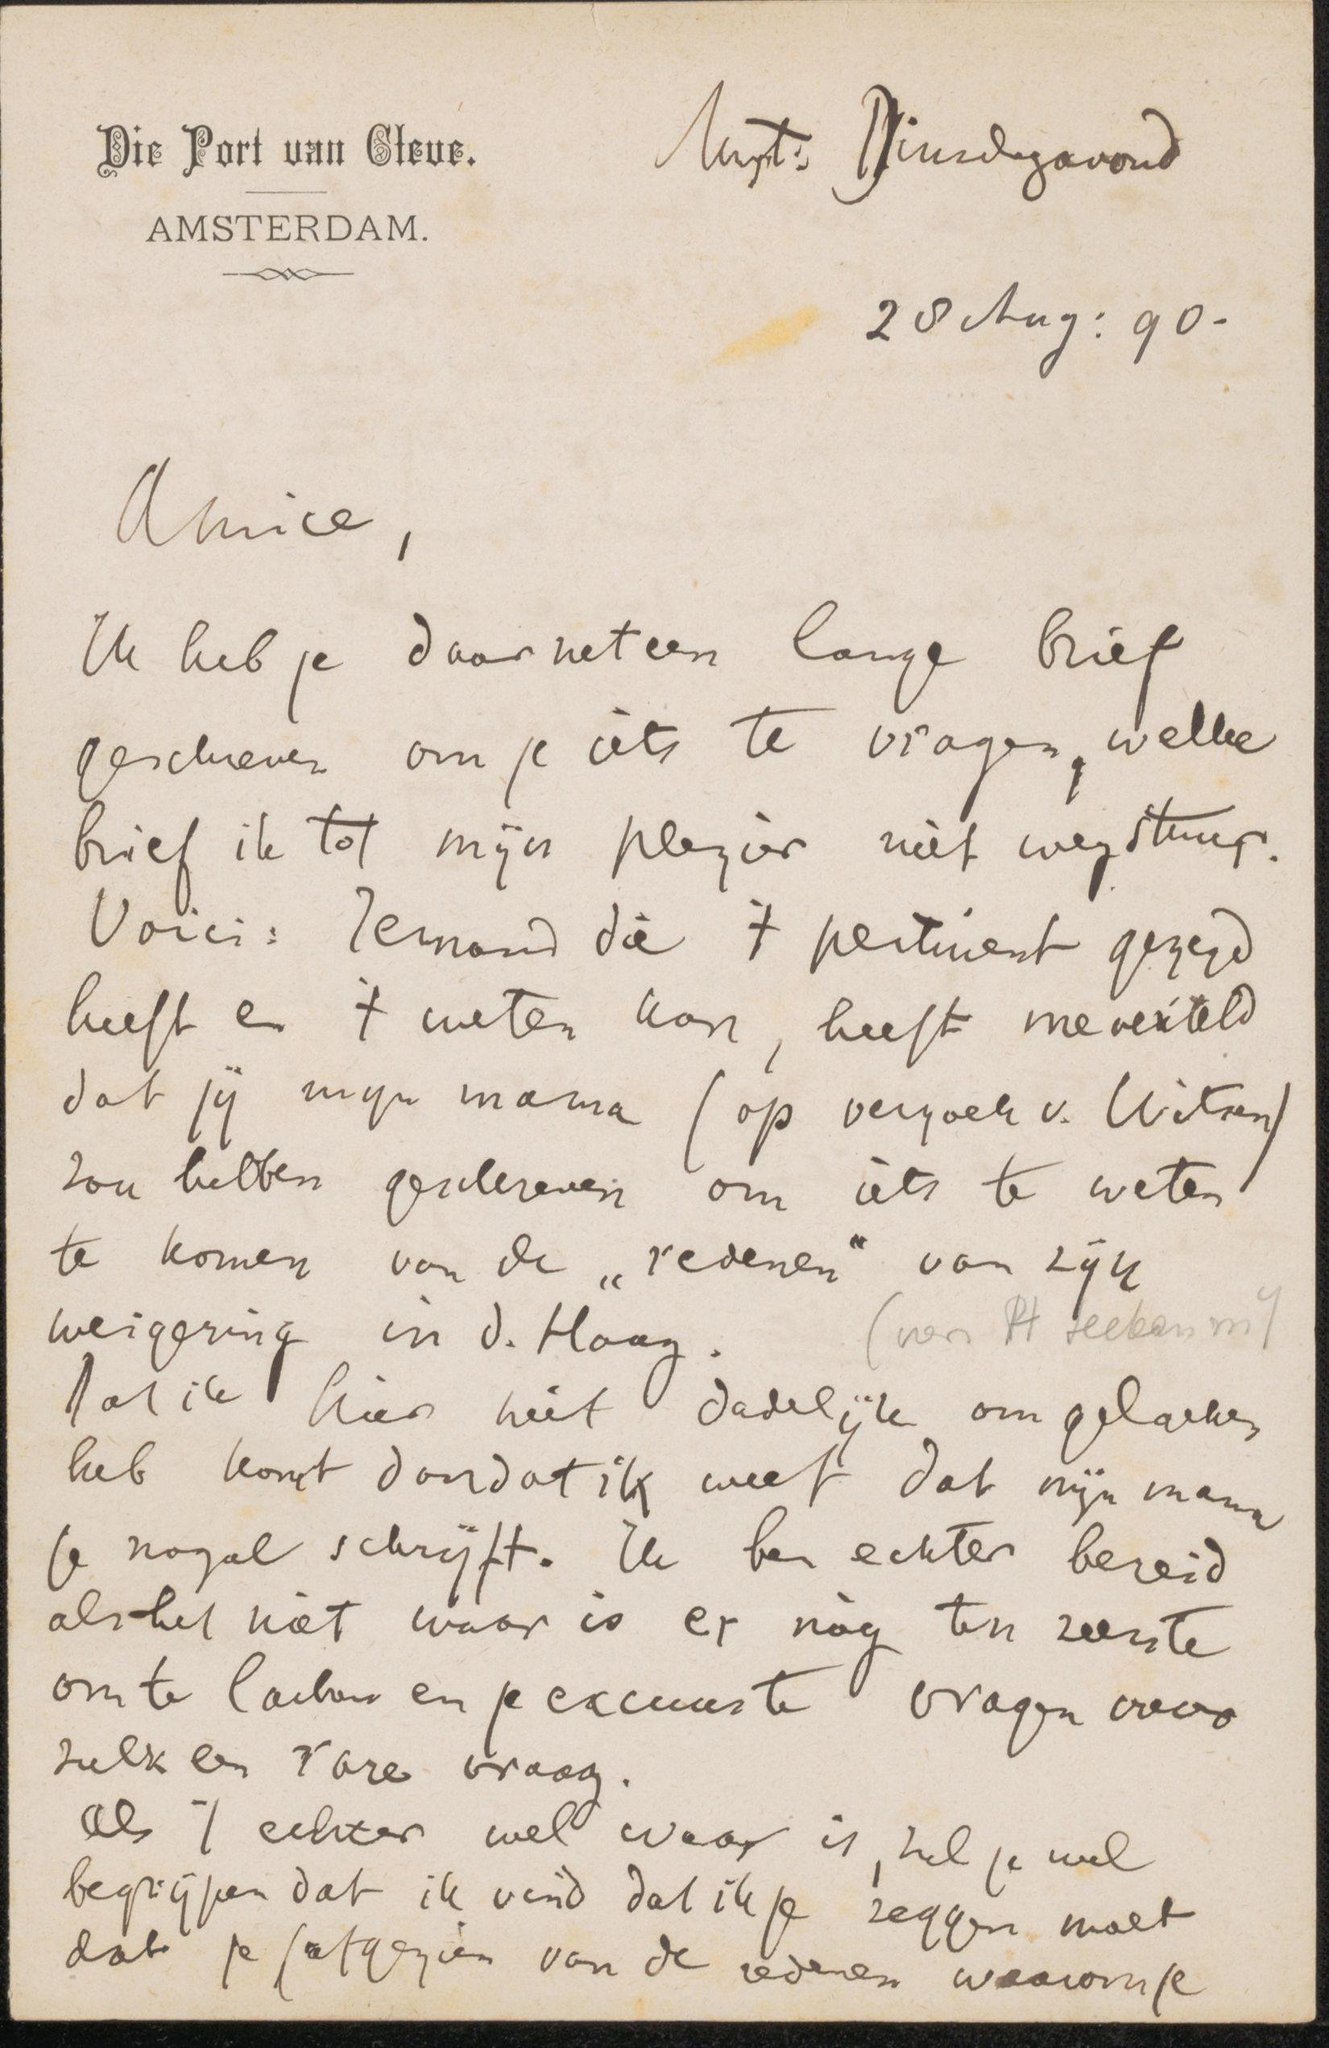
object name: letter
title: Brief aan Jan Veth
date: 1875-1925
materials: ink, paper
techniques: pen, printing, writing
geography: amsterdam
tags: dordrecht, designer, jan veth, willem witsen, passions, emotions, affections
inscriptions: collector's mark: ‘RPK’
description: Gedateerd 28 Aug. 90 in latere hand. Brief bevat aantekening van Jan Veth.